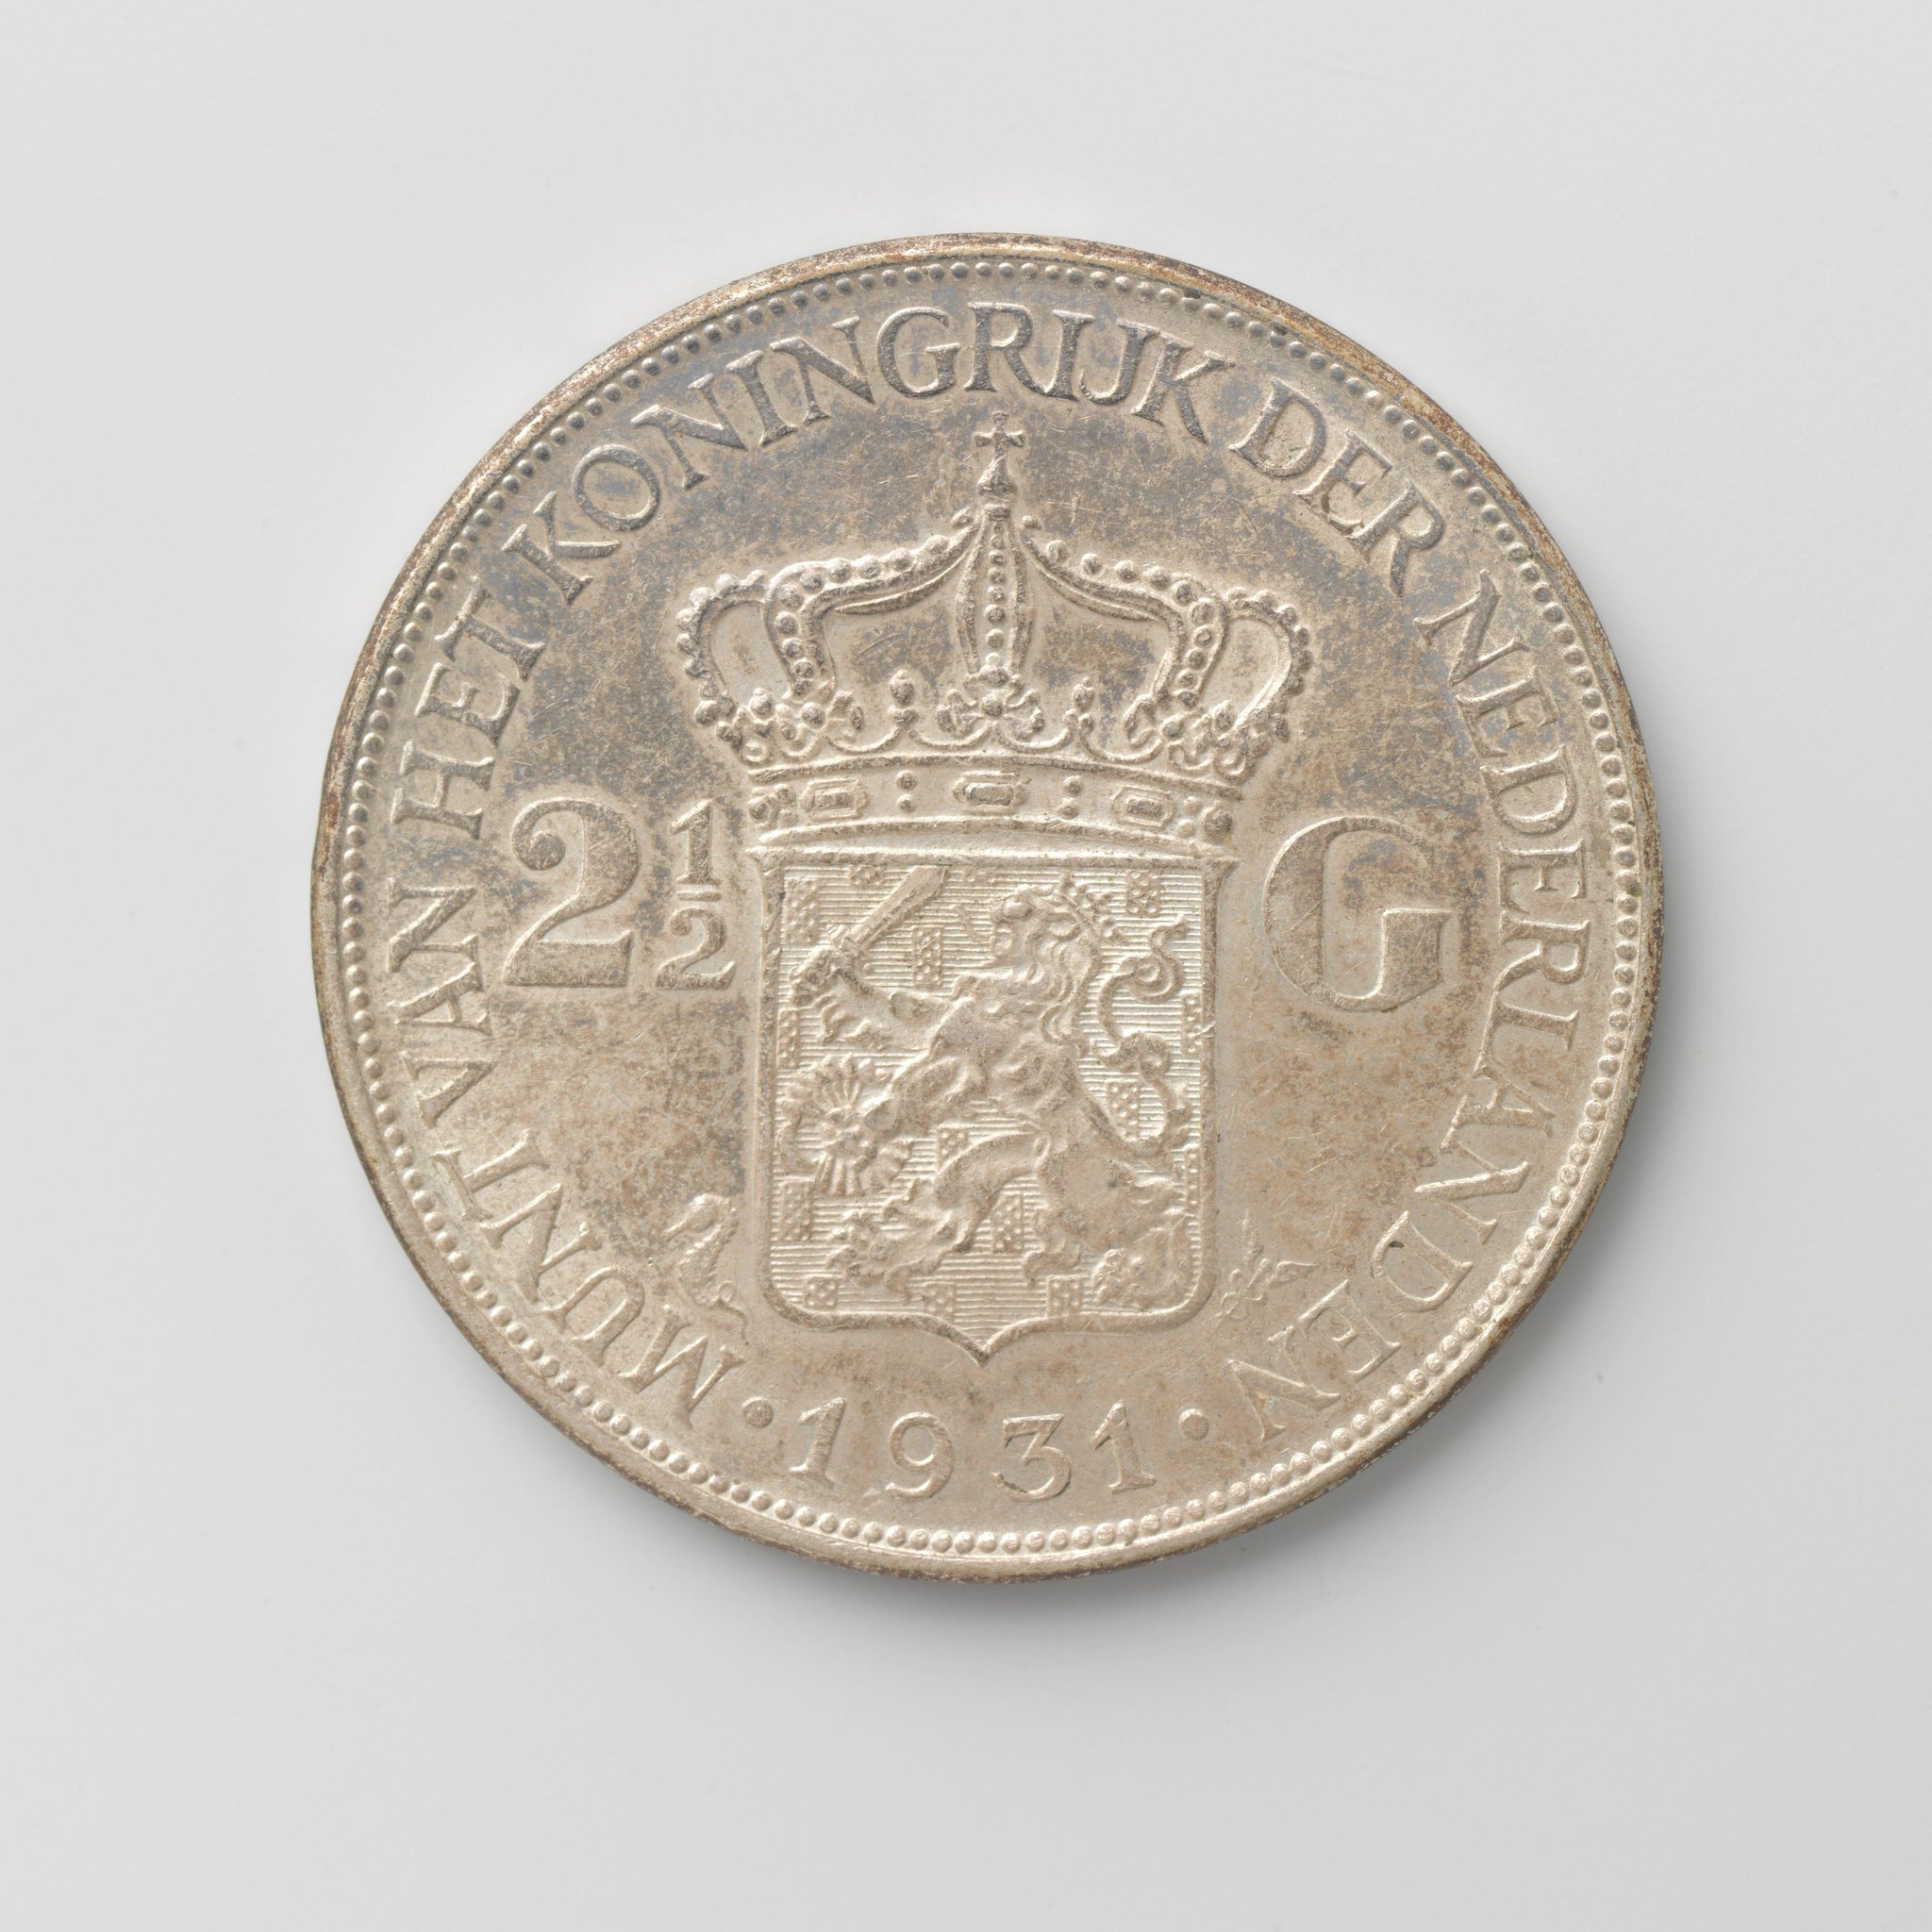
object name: coin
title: Nederlandse 2½ gulden,1931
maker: wilhelmina of the netherlands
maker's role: print maker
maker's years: 1880-1962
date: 1931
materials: silver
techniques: striking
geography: utrecht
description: Zilveren munt. Voorzijde: hoofd naar links. Keerzijde: tussen waarde-aanduiding 2½ G gekroond rijkswapenschild. Jaartal onderaan in omschrift. Randschrift.